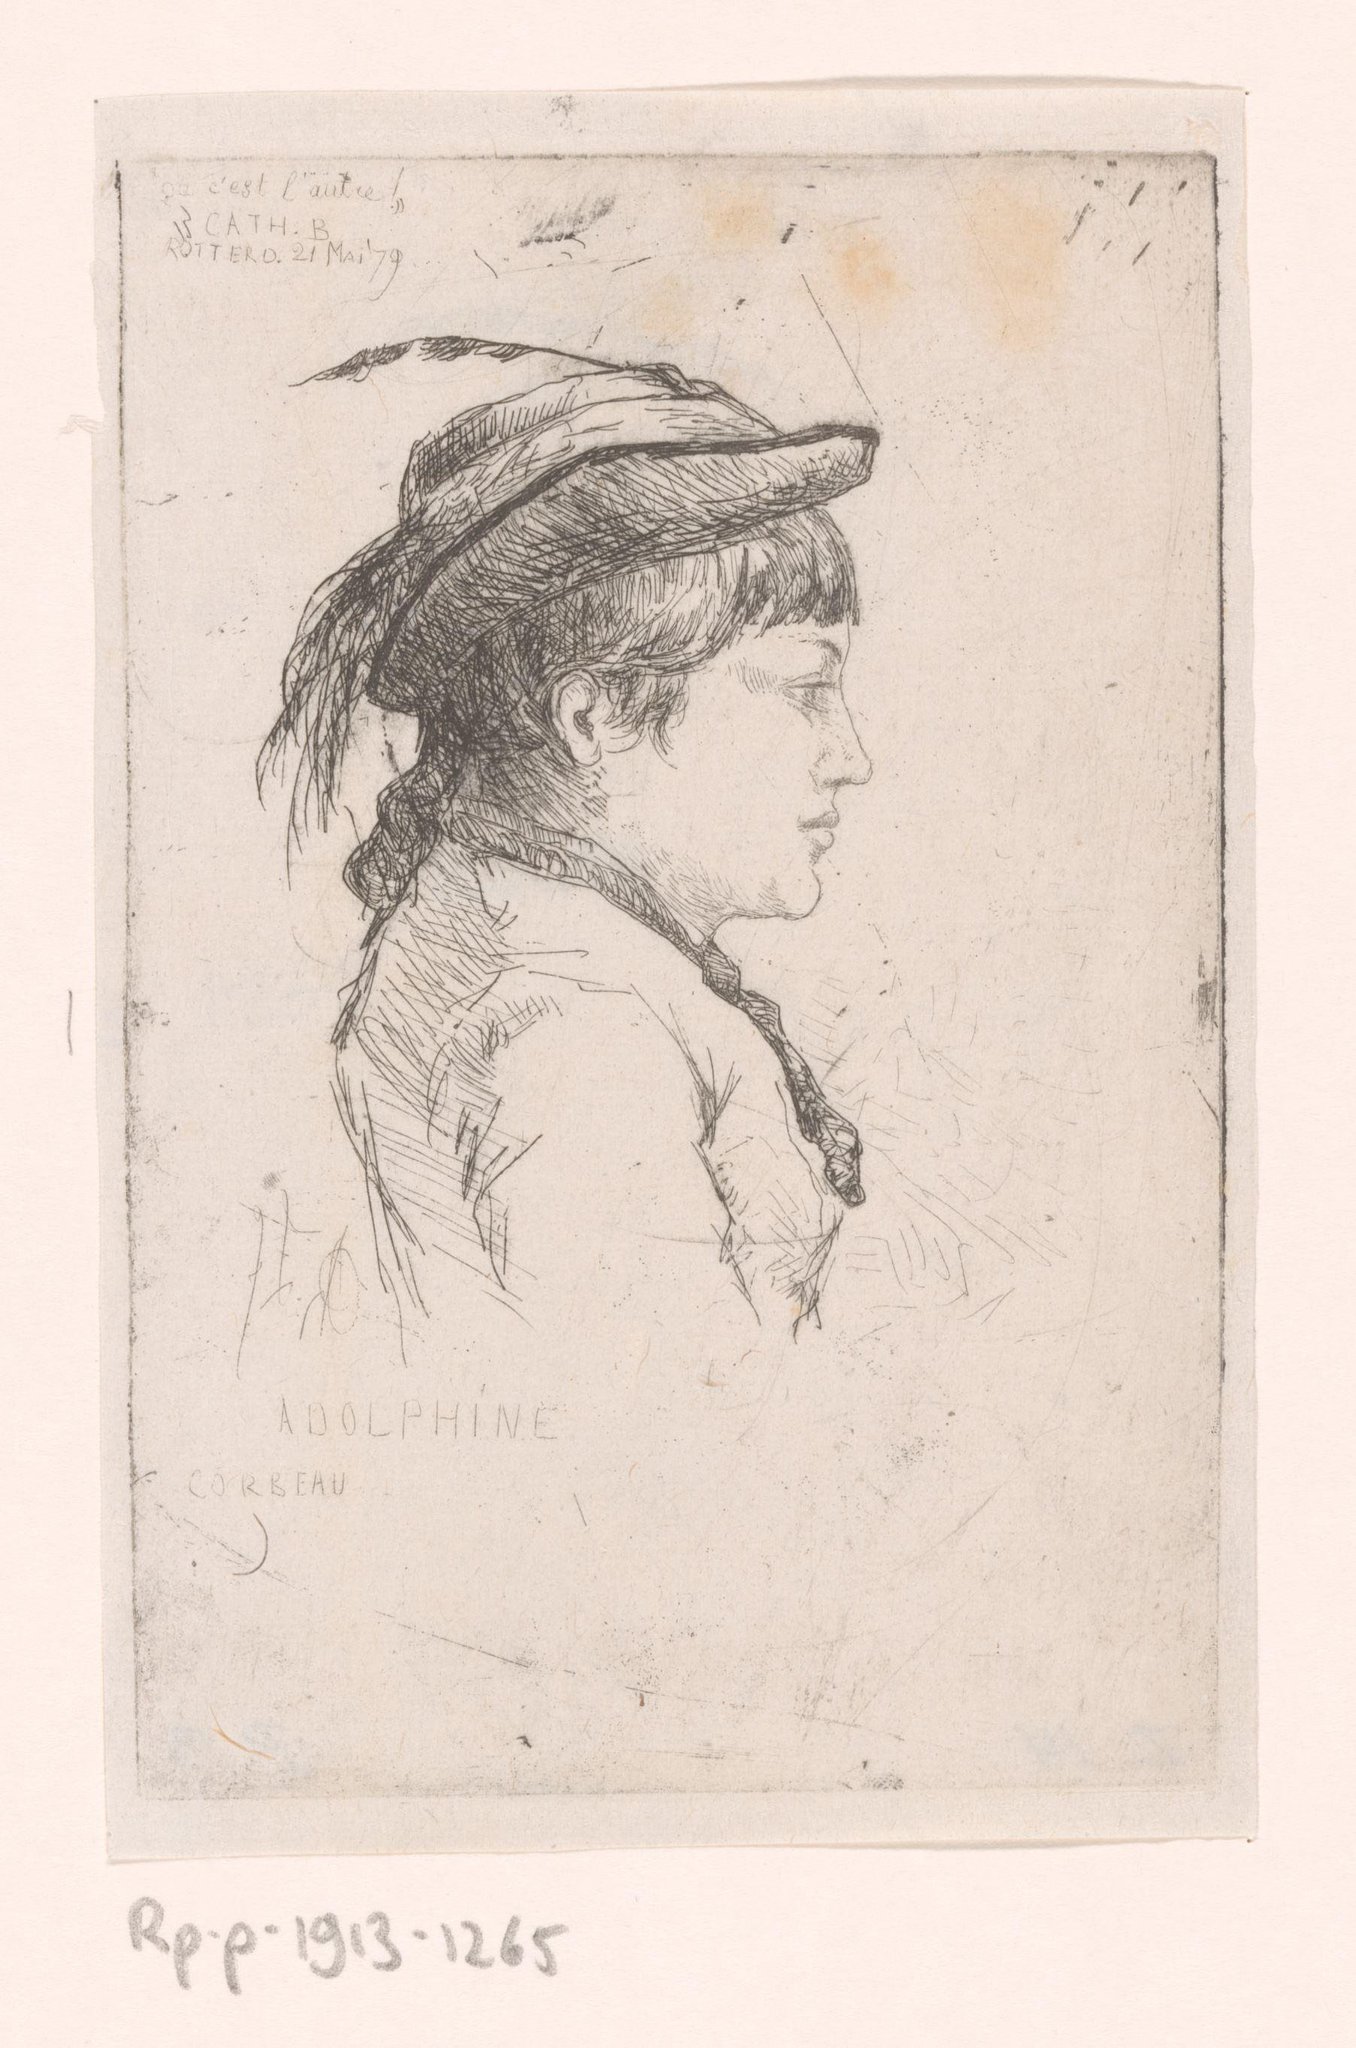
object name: print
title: Meisje met hoed op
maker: philip zilcken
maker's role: draughtsman, painter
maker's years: 1857-1930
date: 1879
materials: paper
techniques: etching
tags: girl (child between toddler and youth), head-gear: hat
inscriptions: inscription: ‘Adolphine/ Corbeau’, inscription: ‘Ca c'est l'autre!/ Cath. B/ Rotterd. 21 Mai '79’, collector's mark: Lugt 2233